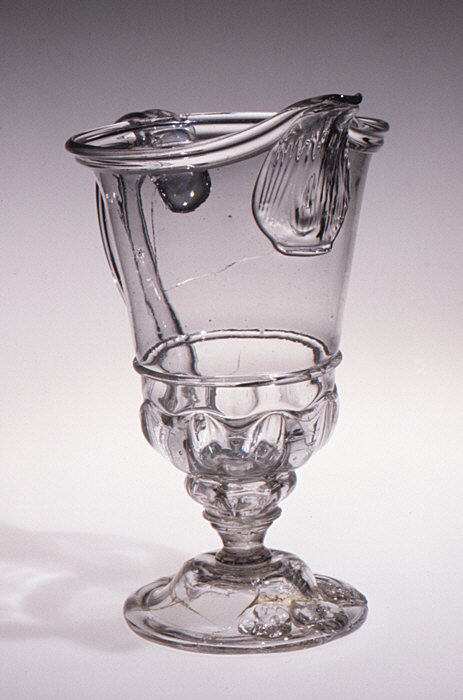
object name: ewer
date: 1667-1700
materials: glass